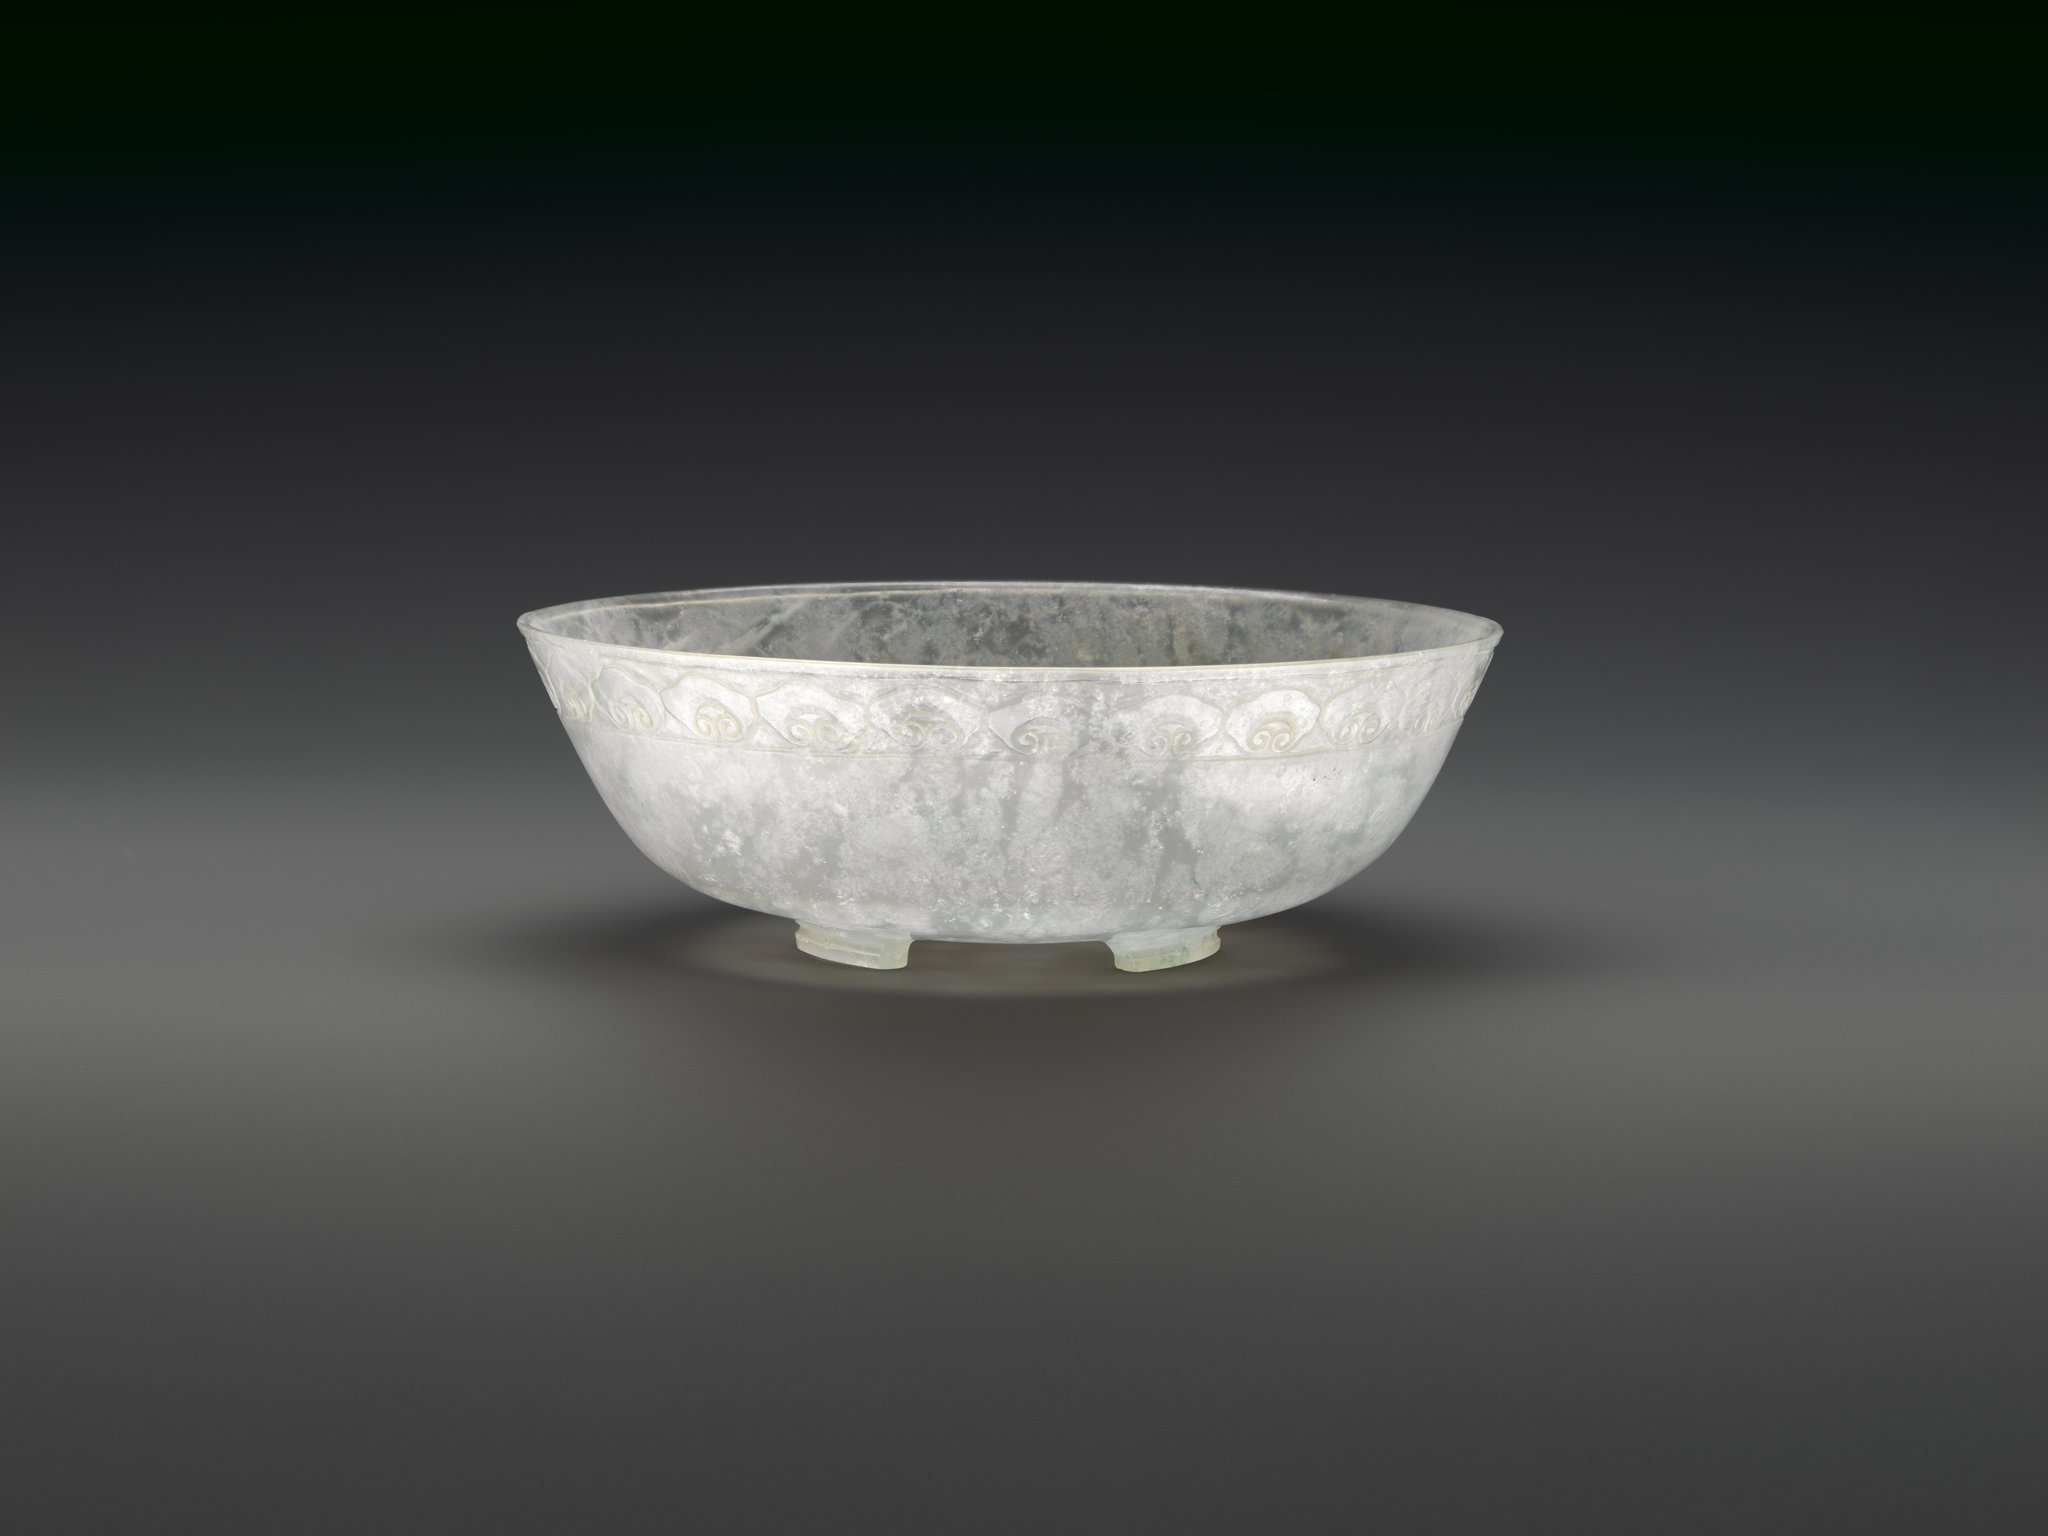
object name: bowl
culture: chinese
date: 1736-1795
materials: jade